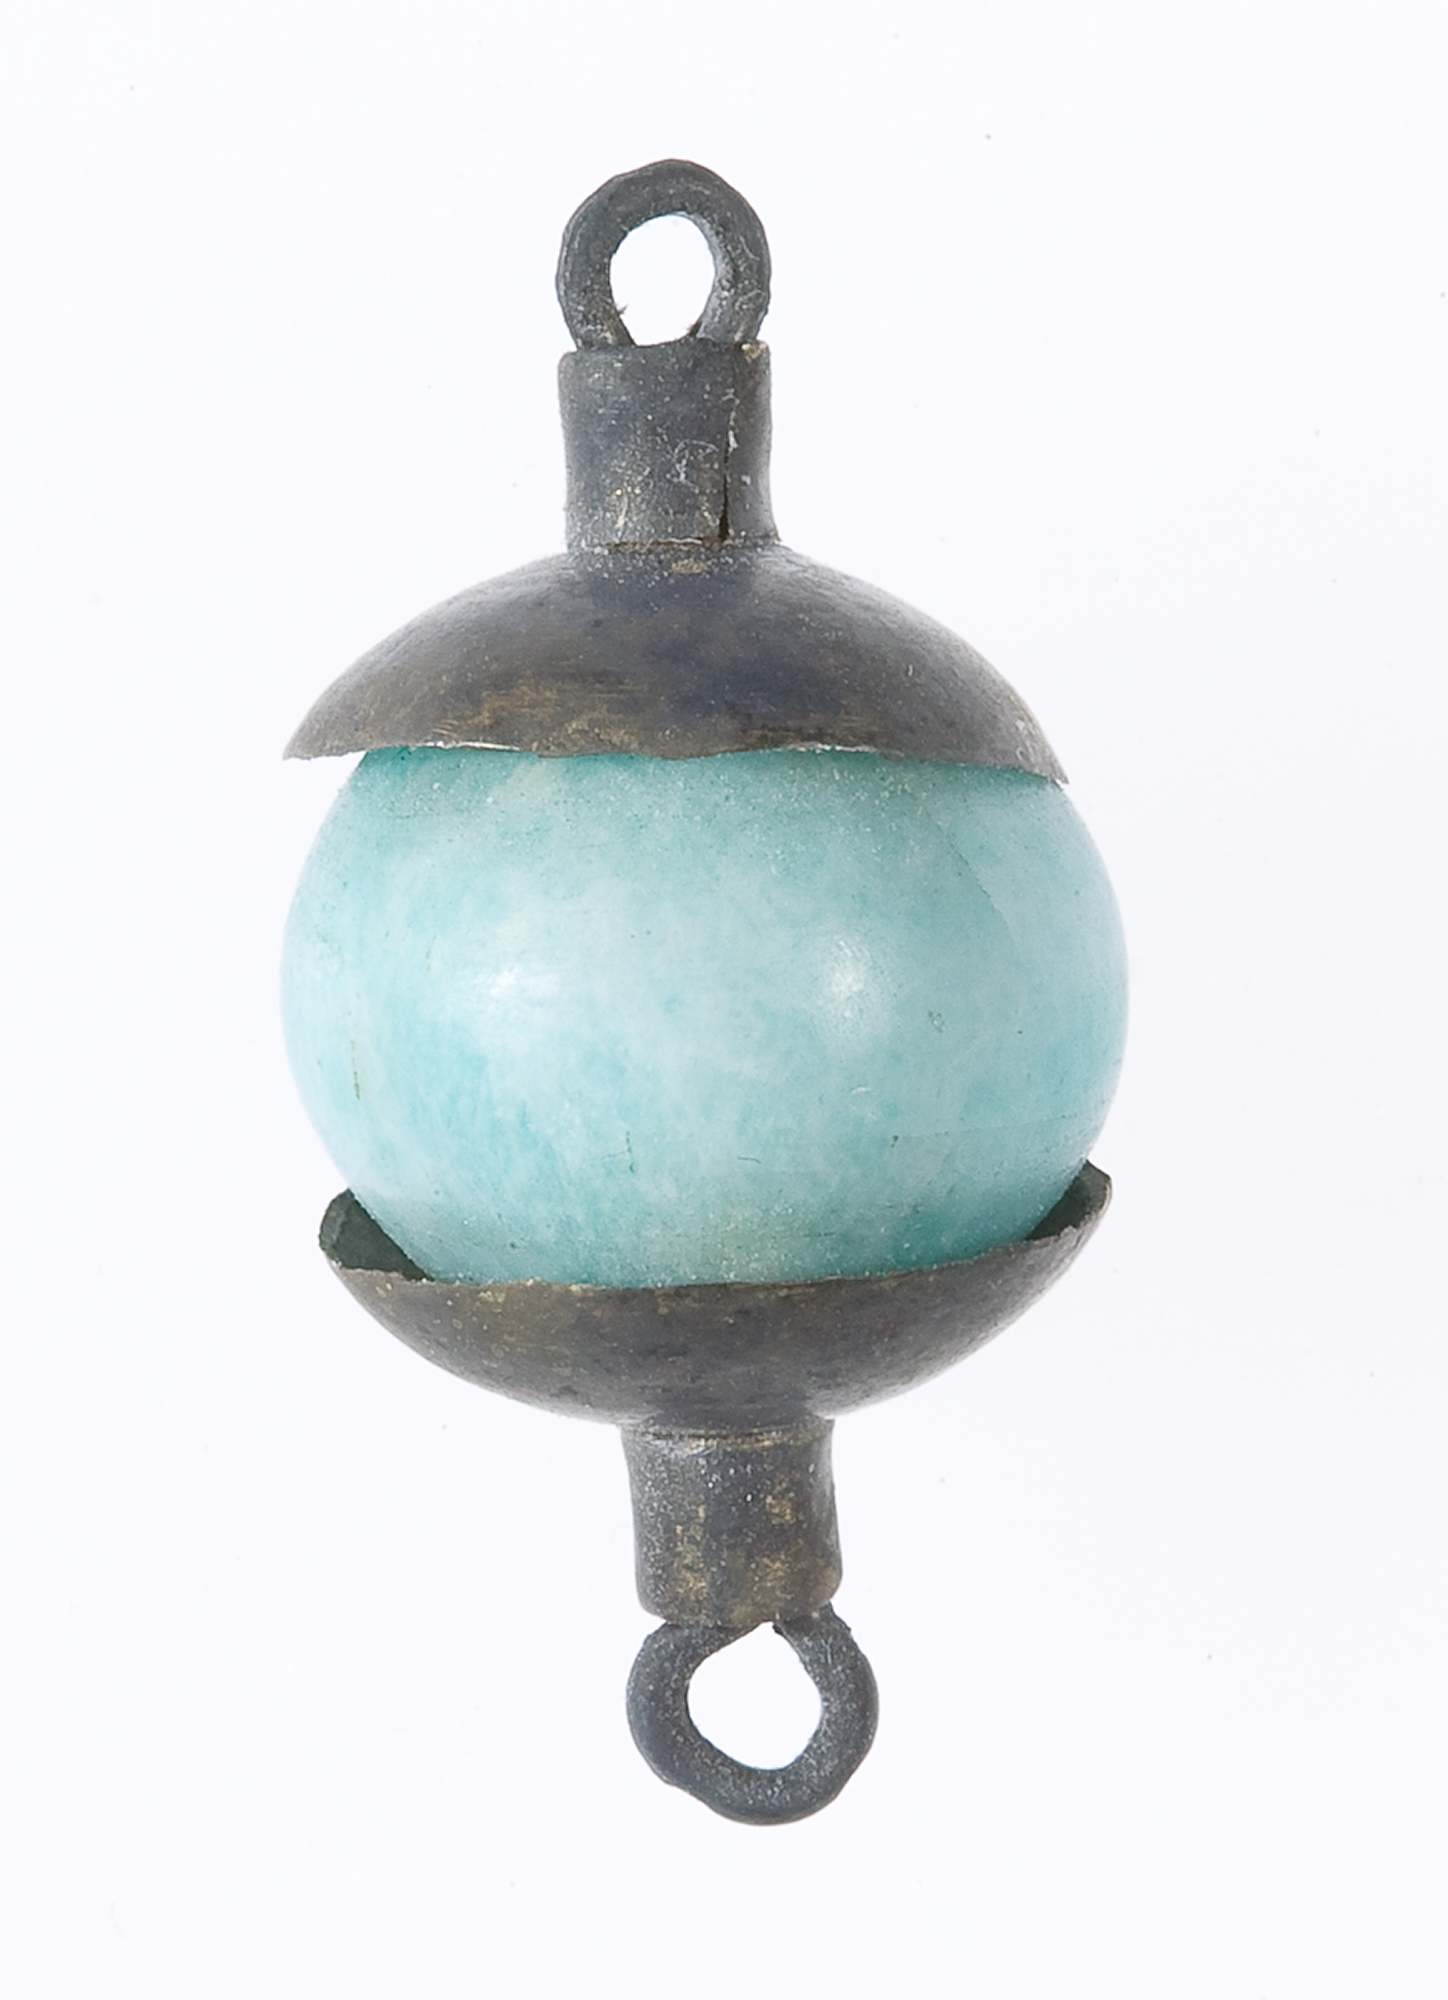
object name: necklace ornament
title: Bead from a Necklace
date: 1200-1186 BCE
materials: gold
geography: egypt